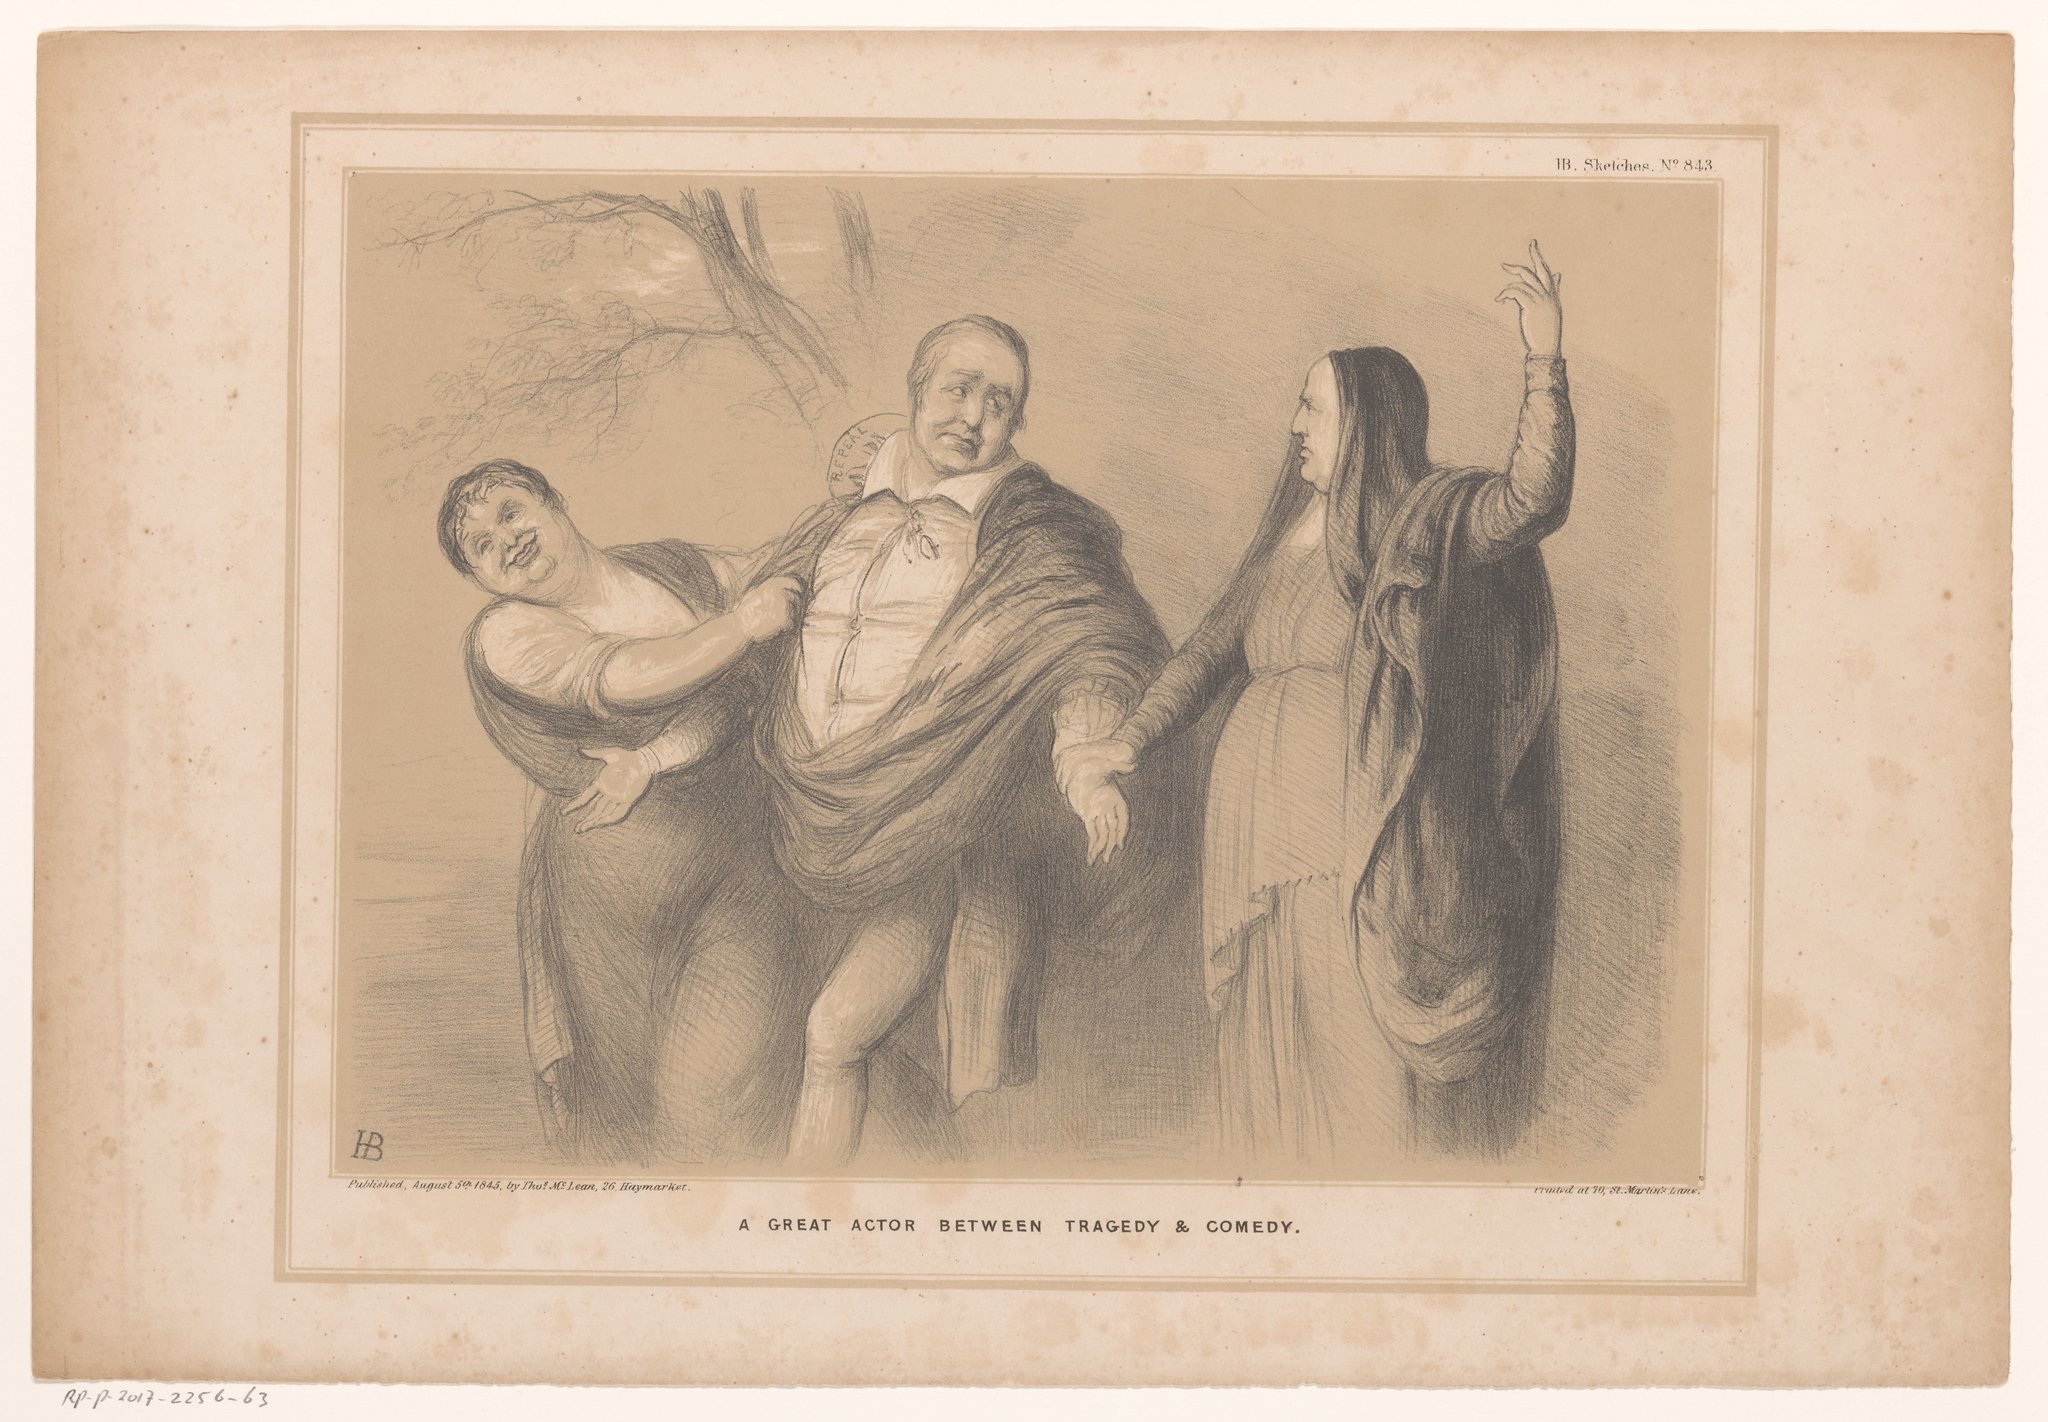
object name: print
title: A great actor between tragedy & comedy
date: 1845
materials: paper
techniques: tone lithography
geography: london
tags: london, david garrick, politician, tragedy, comedy, political caricatures and satires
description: Spotprent uit 1845 met premier Robert Peel verscheurd tussen tragedie (Sir Robert Inglis) en komedie (Daniel O'Connell). Naar het schilderij van de acteur David Garrick door Joshua Reynolds. Uitgegeven als nr. 843 in de serie HB Sketches.